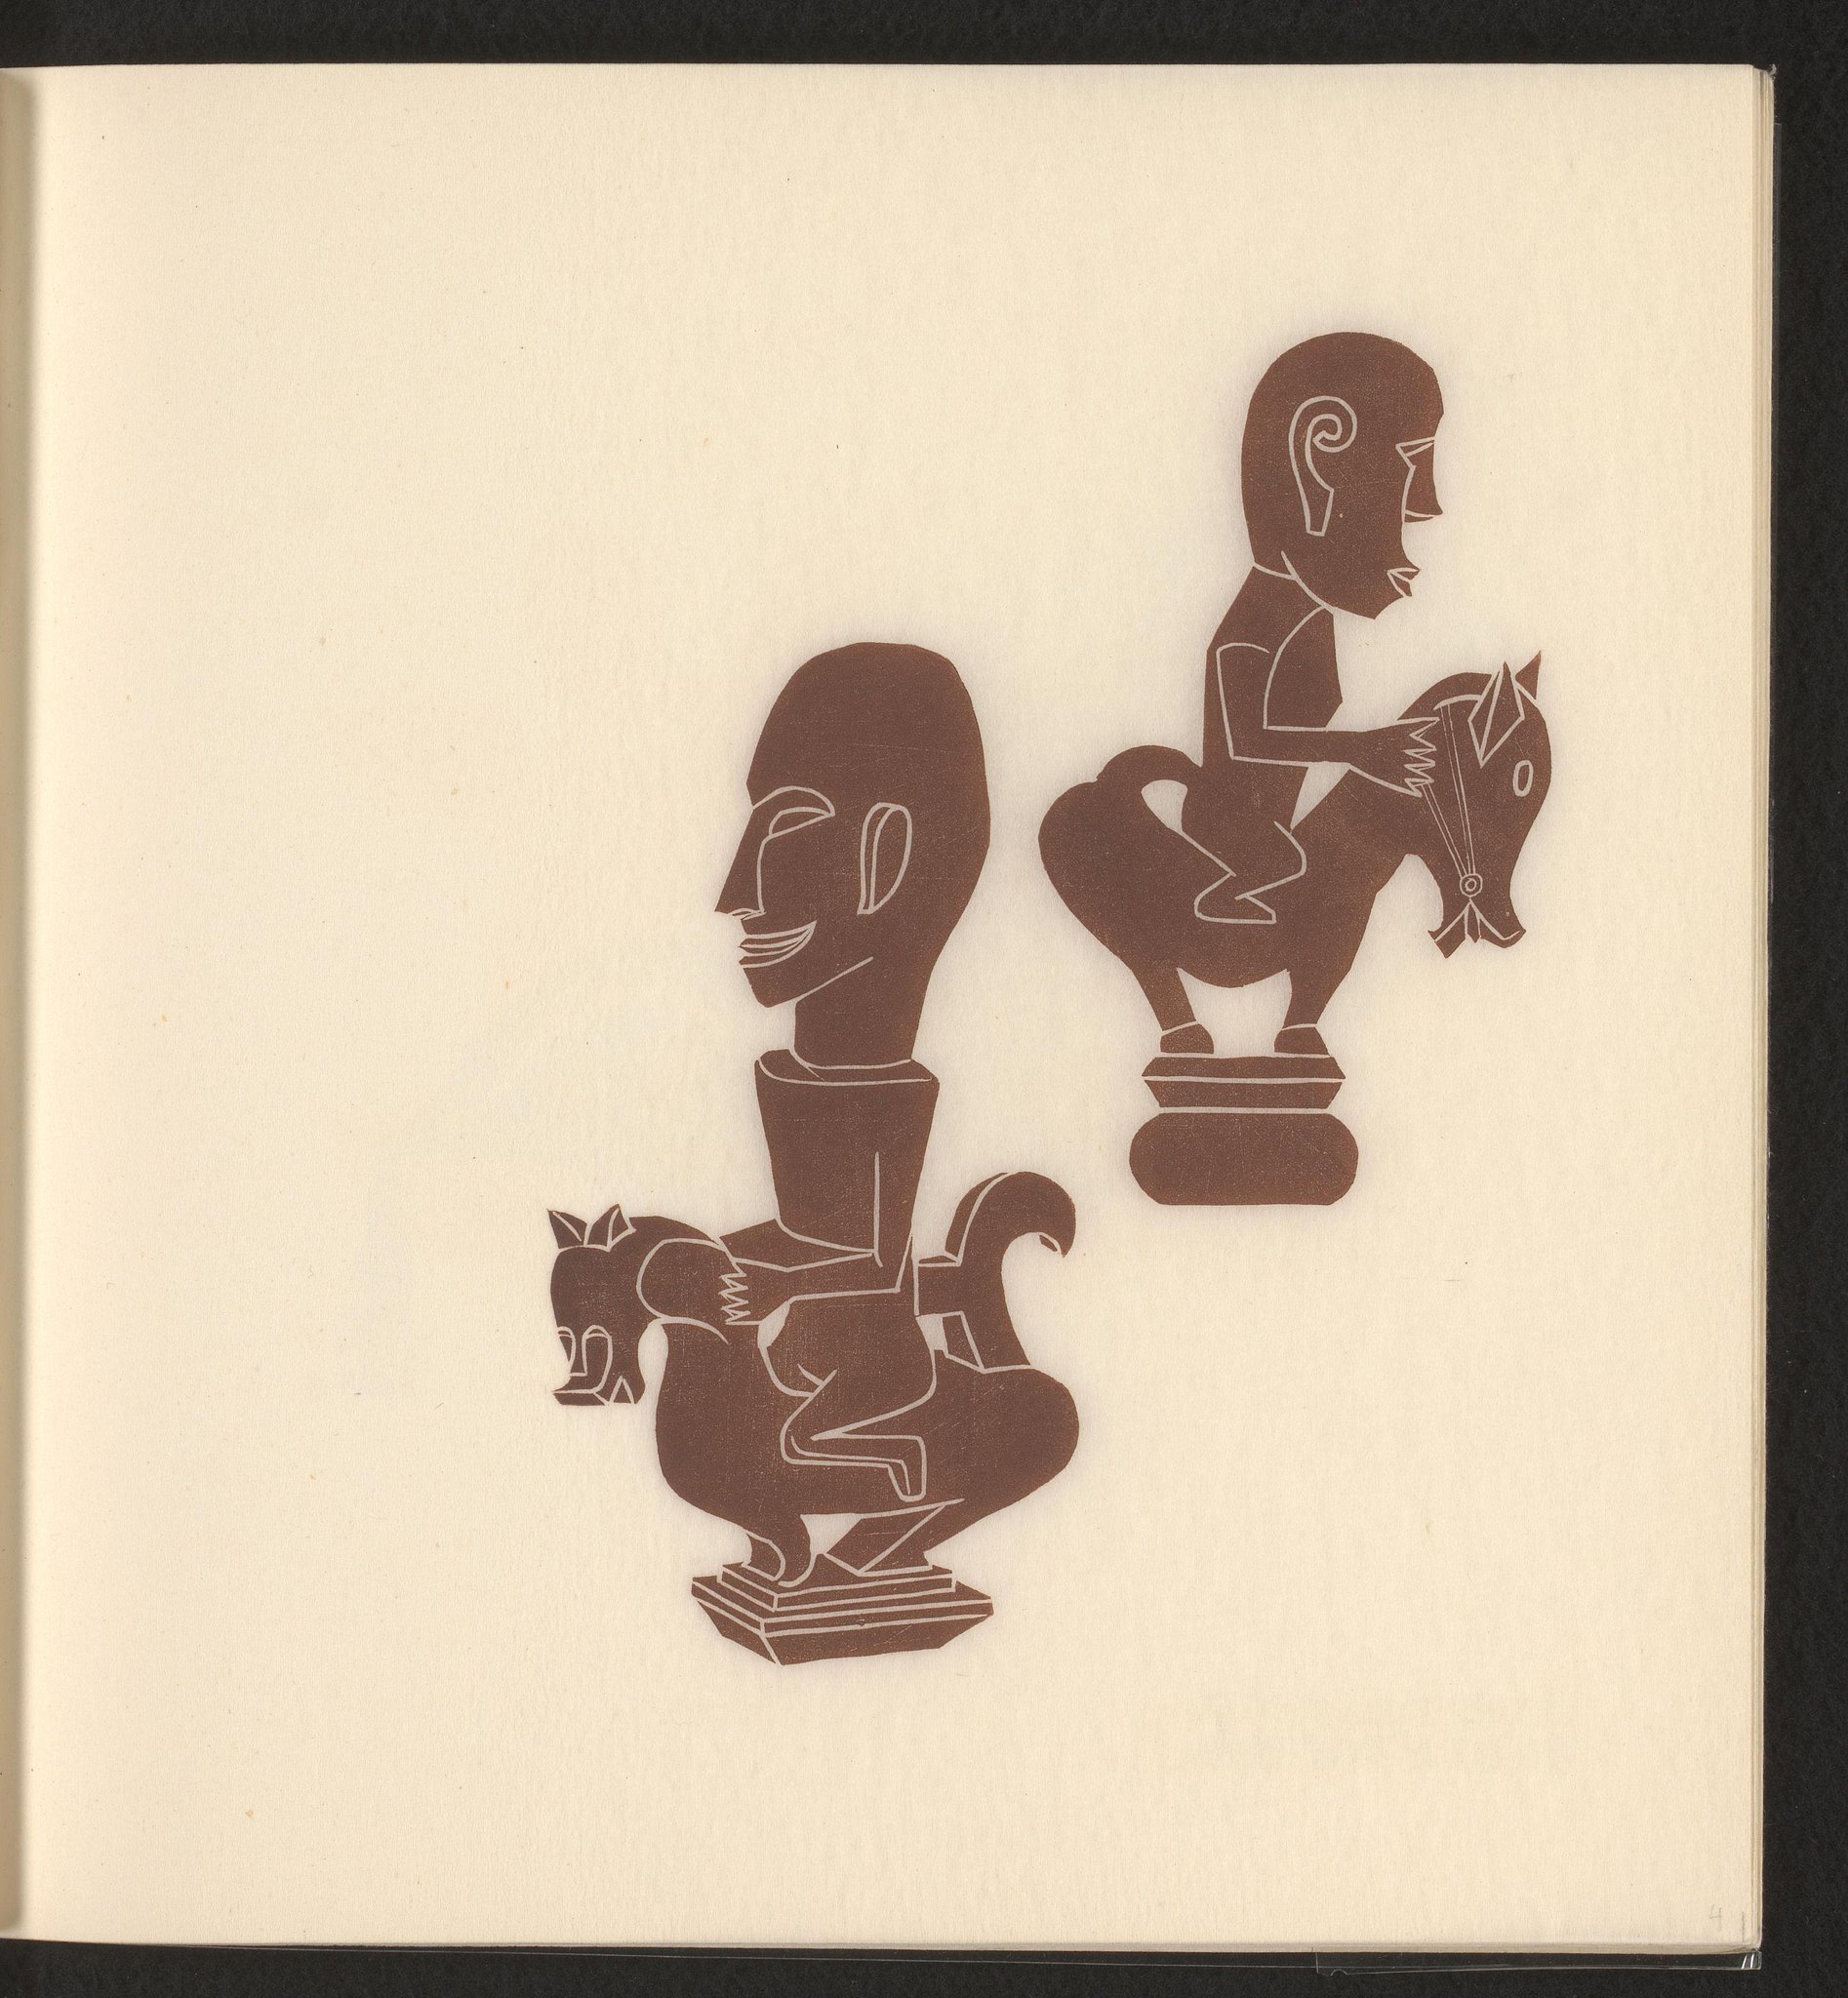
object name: print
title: Stopbekroning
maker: reijer stolk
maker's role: draughtsman, print maker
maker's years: 1896-1945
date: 1942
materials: paper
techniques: woodcut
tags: riding a horse, ass, or mule; rider, horseman, indonesia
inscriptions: date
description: Twee stoppen in de vorm van ruiters te paard. Onderdeel van album 'Tien bladen sierkunst uit ons Oost-Indië'.